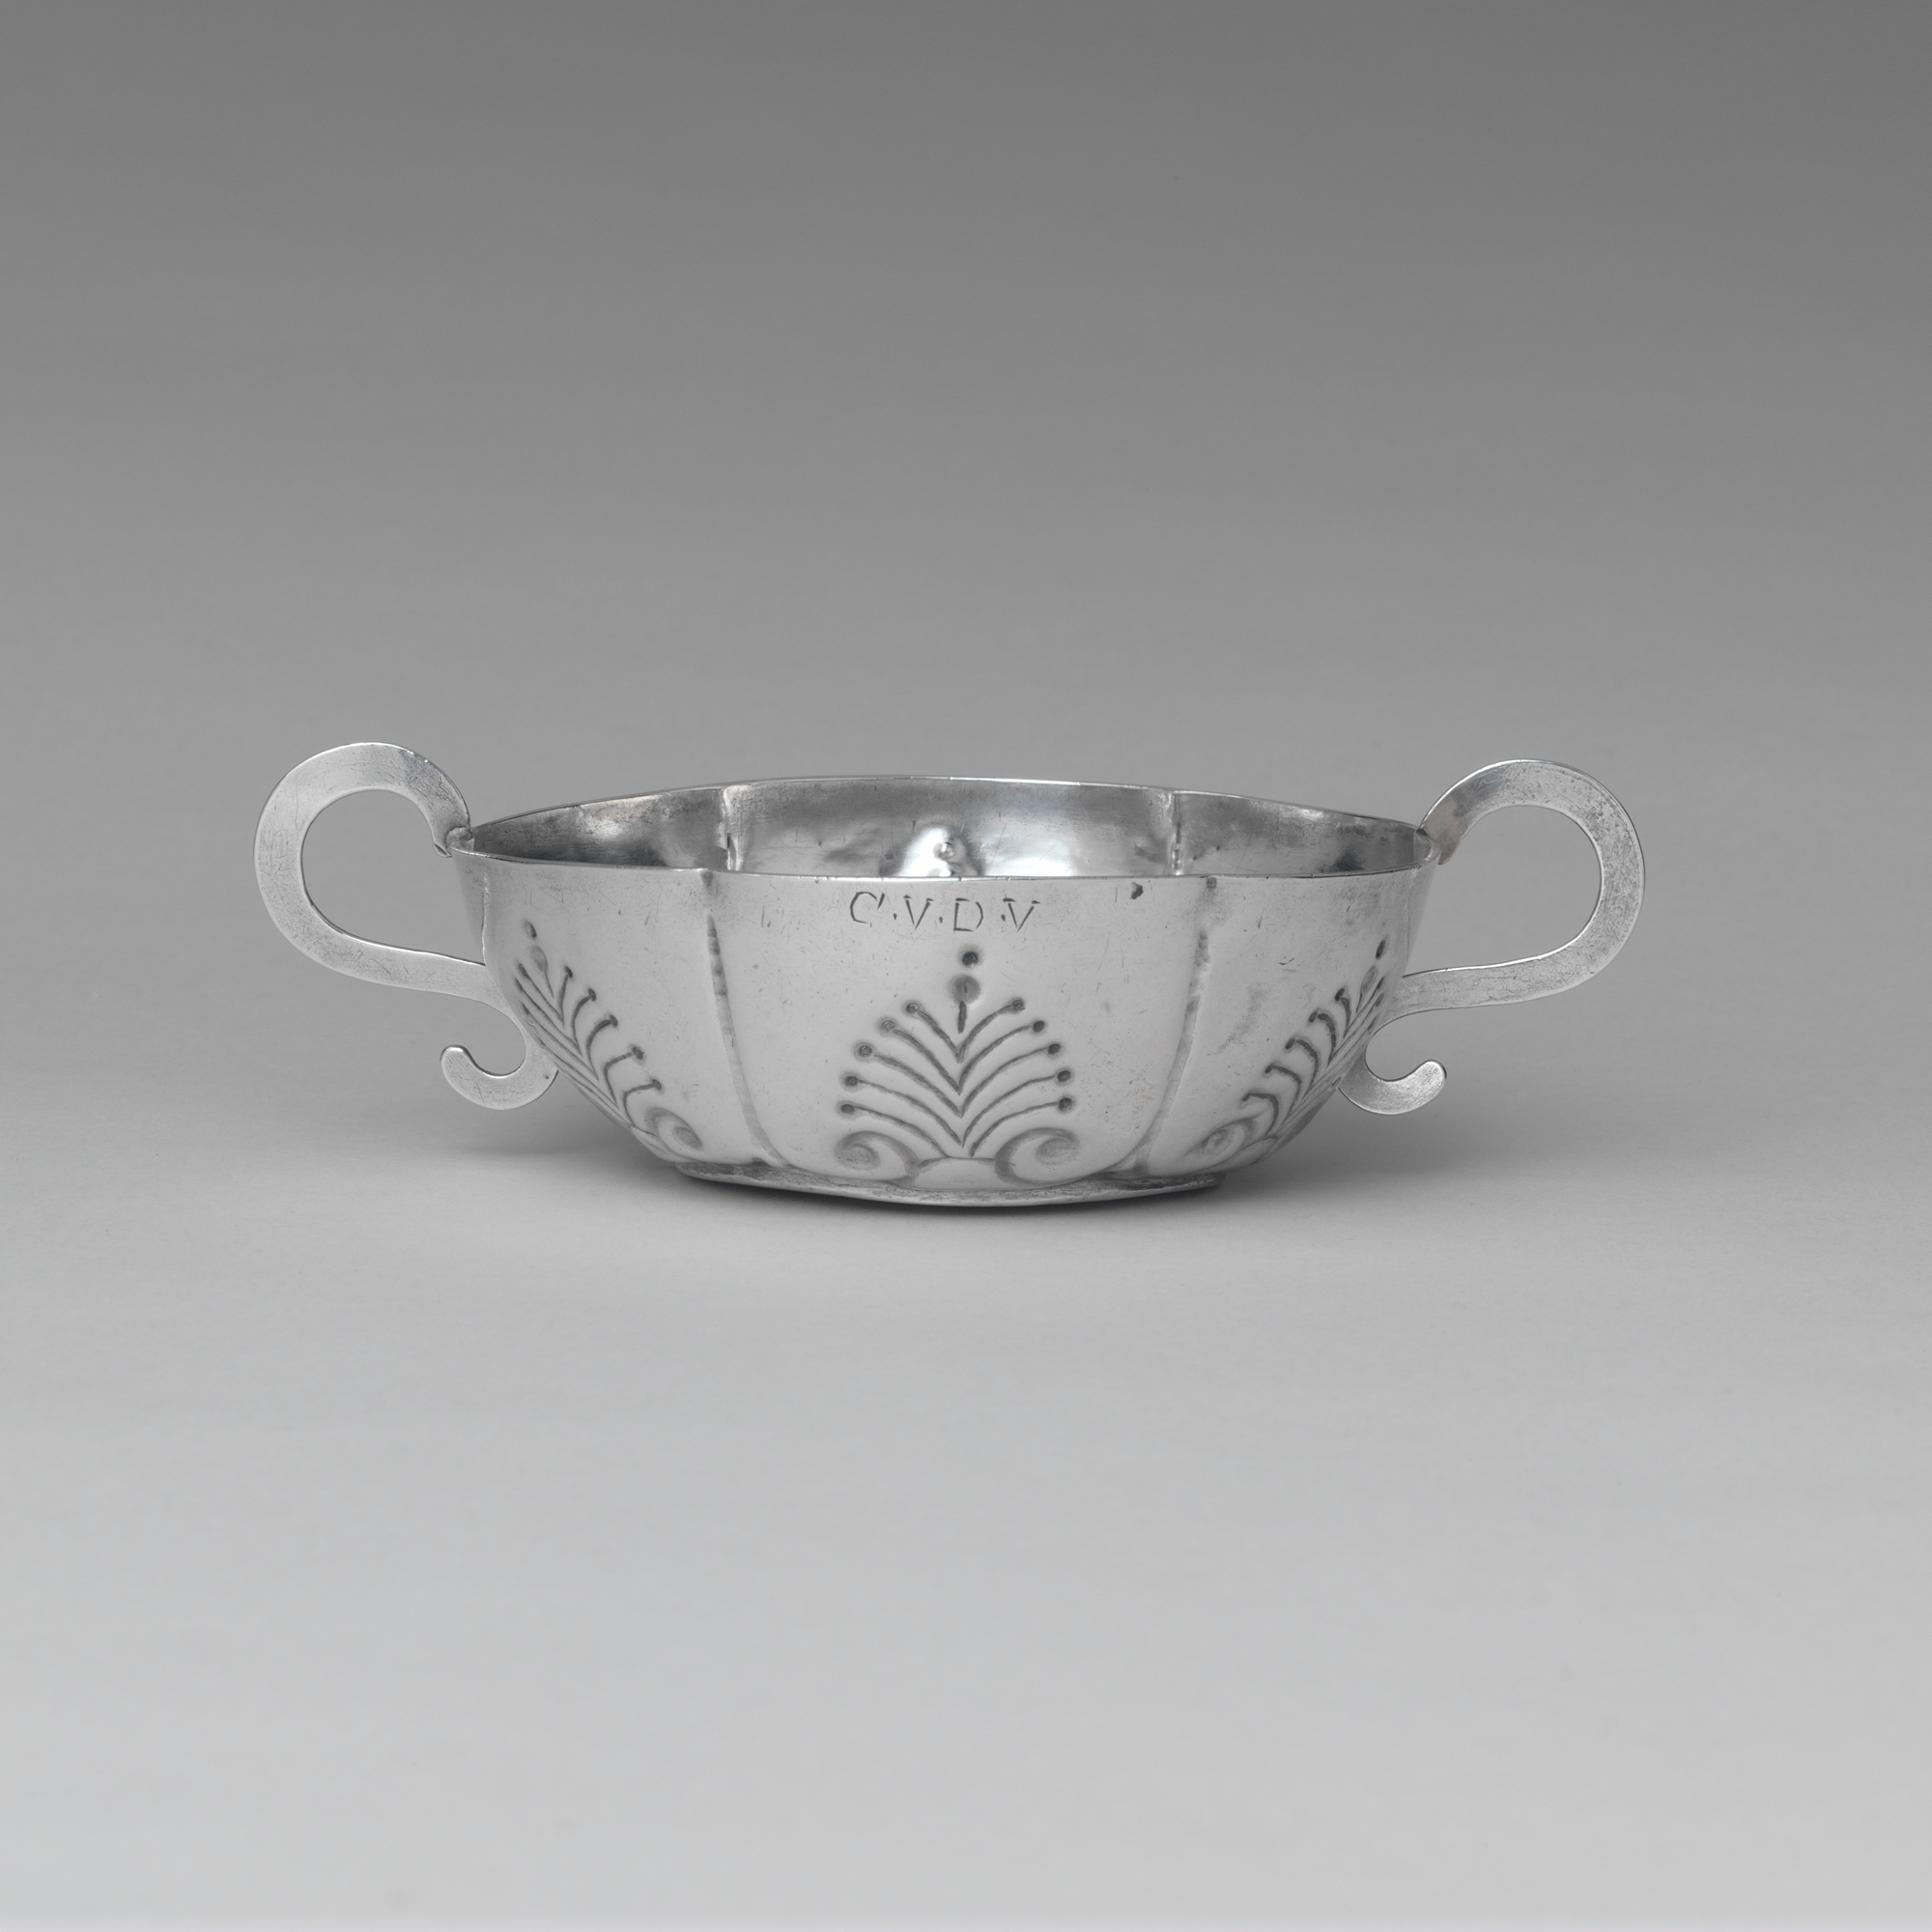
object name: cup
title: Dram Cup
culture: american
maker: jacob boelen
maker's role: maker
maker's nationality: american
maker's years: 1657-1729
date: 1680-1700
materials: silver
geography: united states